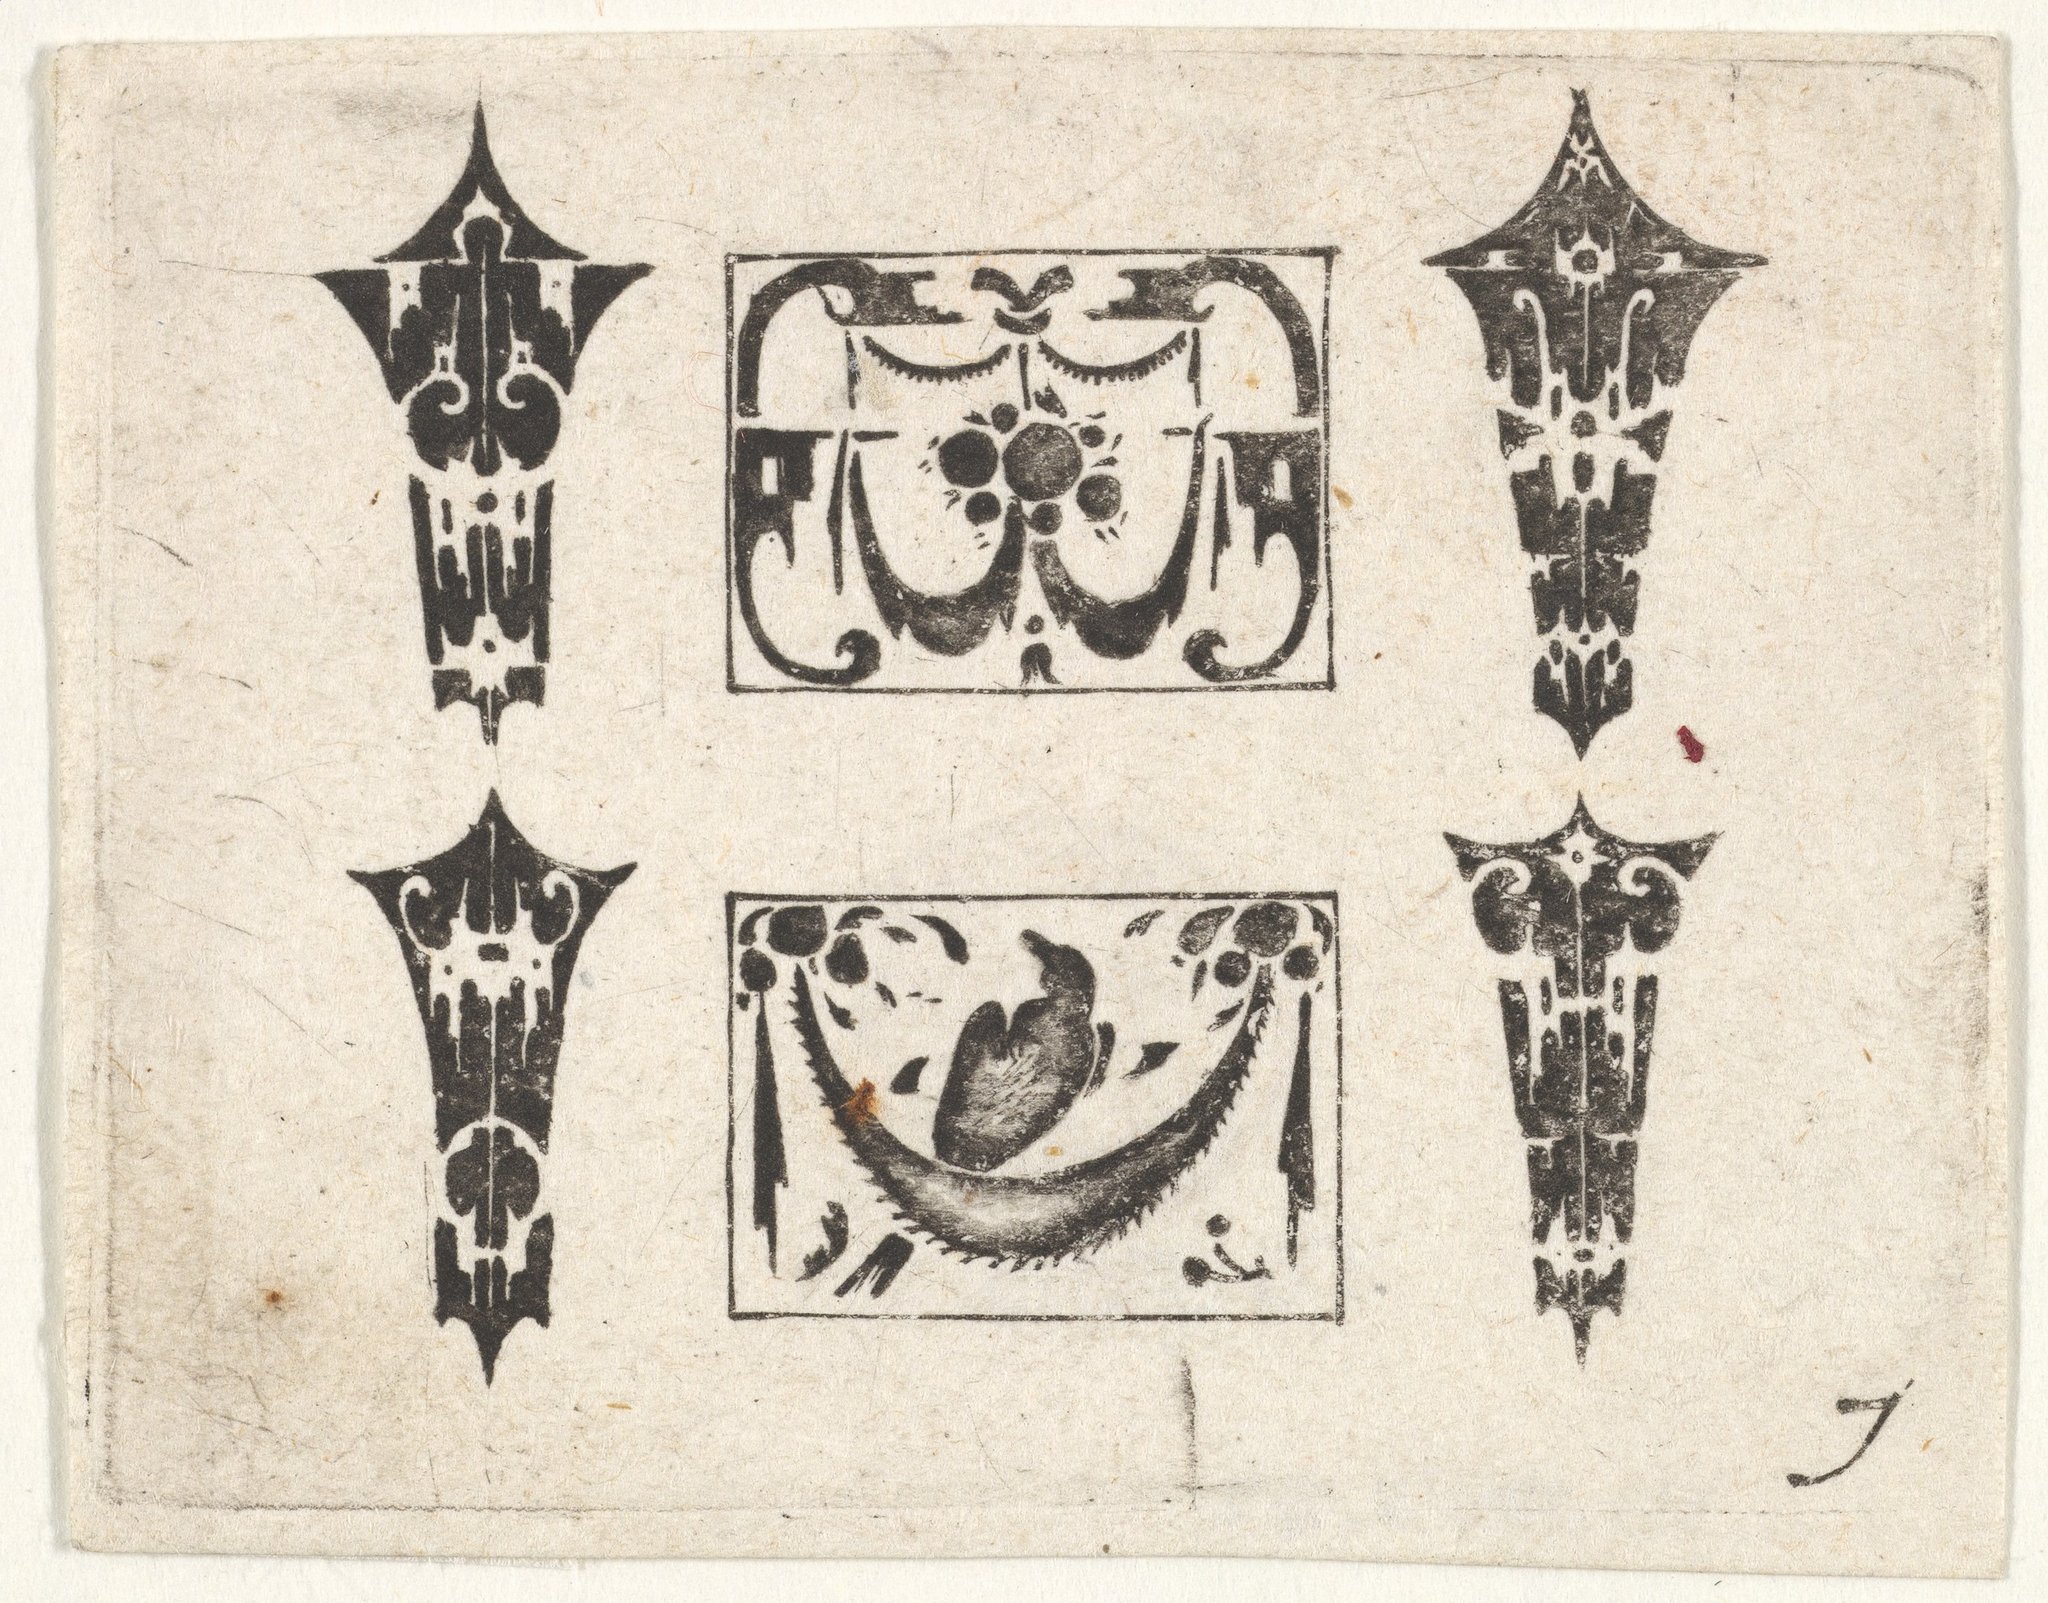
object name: print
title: Blackwork Print with Two Horizontal Panels and Four Bezels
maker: claes jansz. visscher (ii)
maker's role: artist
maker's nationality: dutch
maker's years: 1586-1652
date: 1620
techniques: embroidery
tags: birds